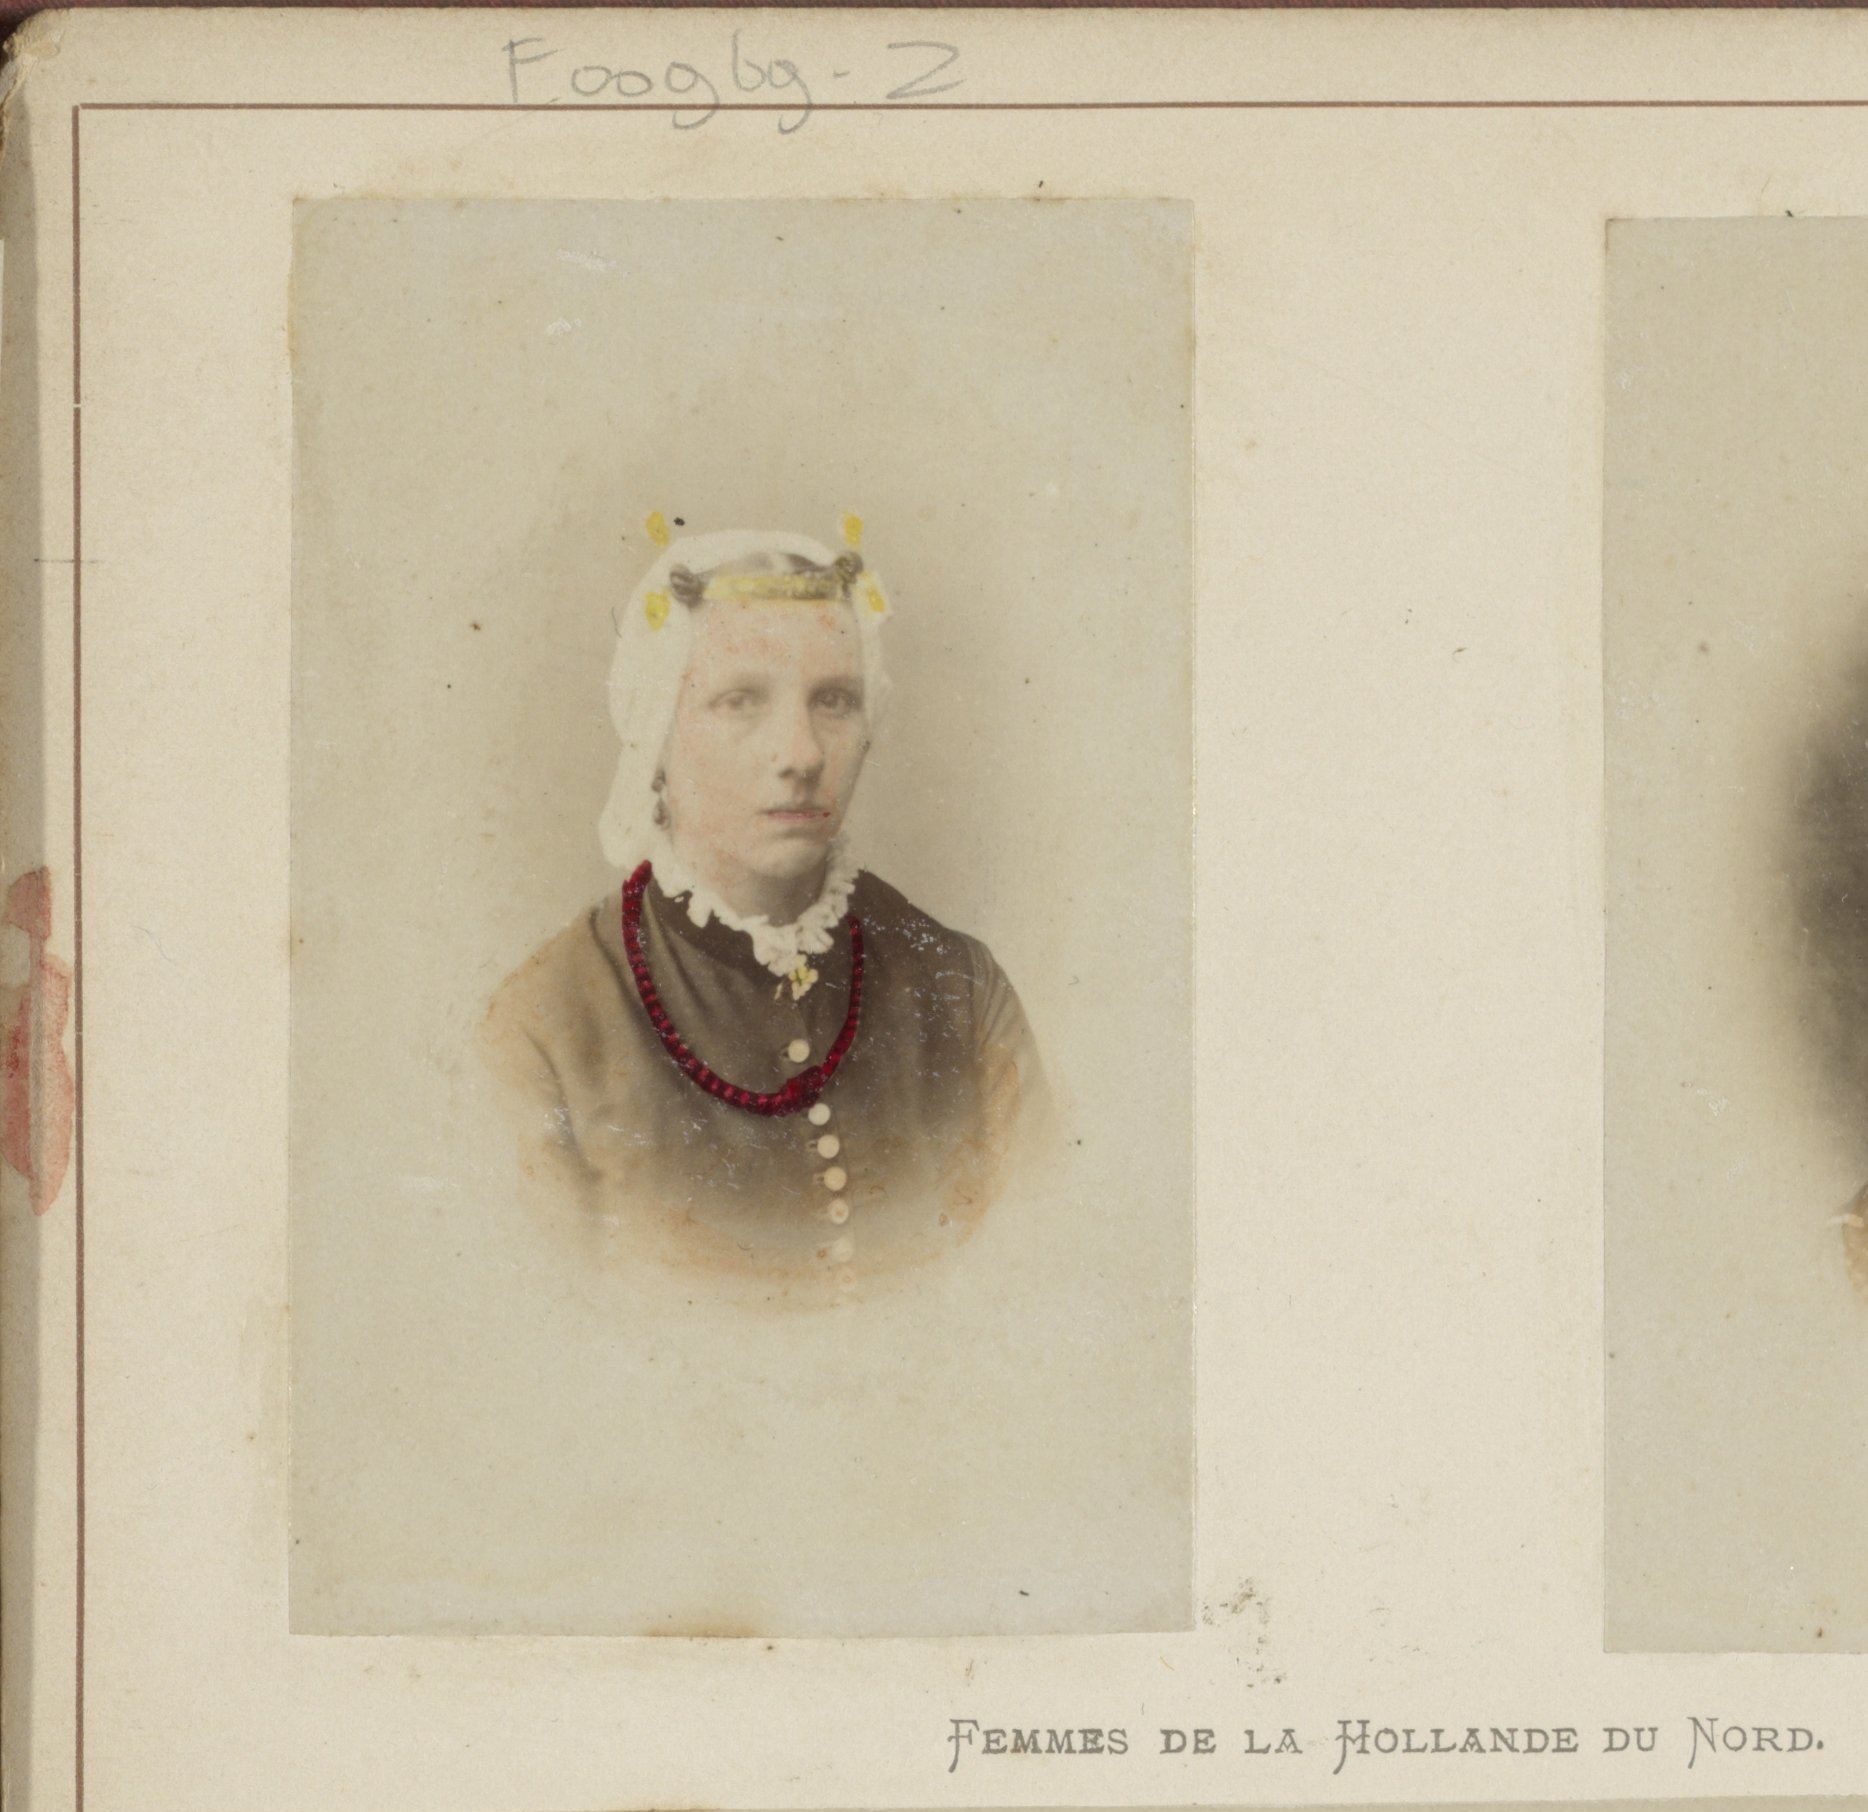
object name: photograph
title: Femmes de la Hollande du Nord.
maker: andries jager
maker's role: publisher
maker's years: 1825-1905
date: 1878-1890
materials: cardboard, paper, photographic support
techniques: albumen print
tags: historical persons, clothing for the upper part of the body, head-gear: cap, folk costume, regional costume, necklace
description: Onderdeel van Leporelloalbum met 28 foto's van Amsterdam en omstreken.